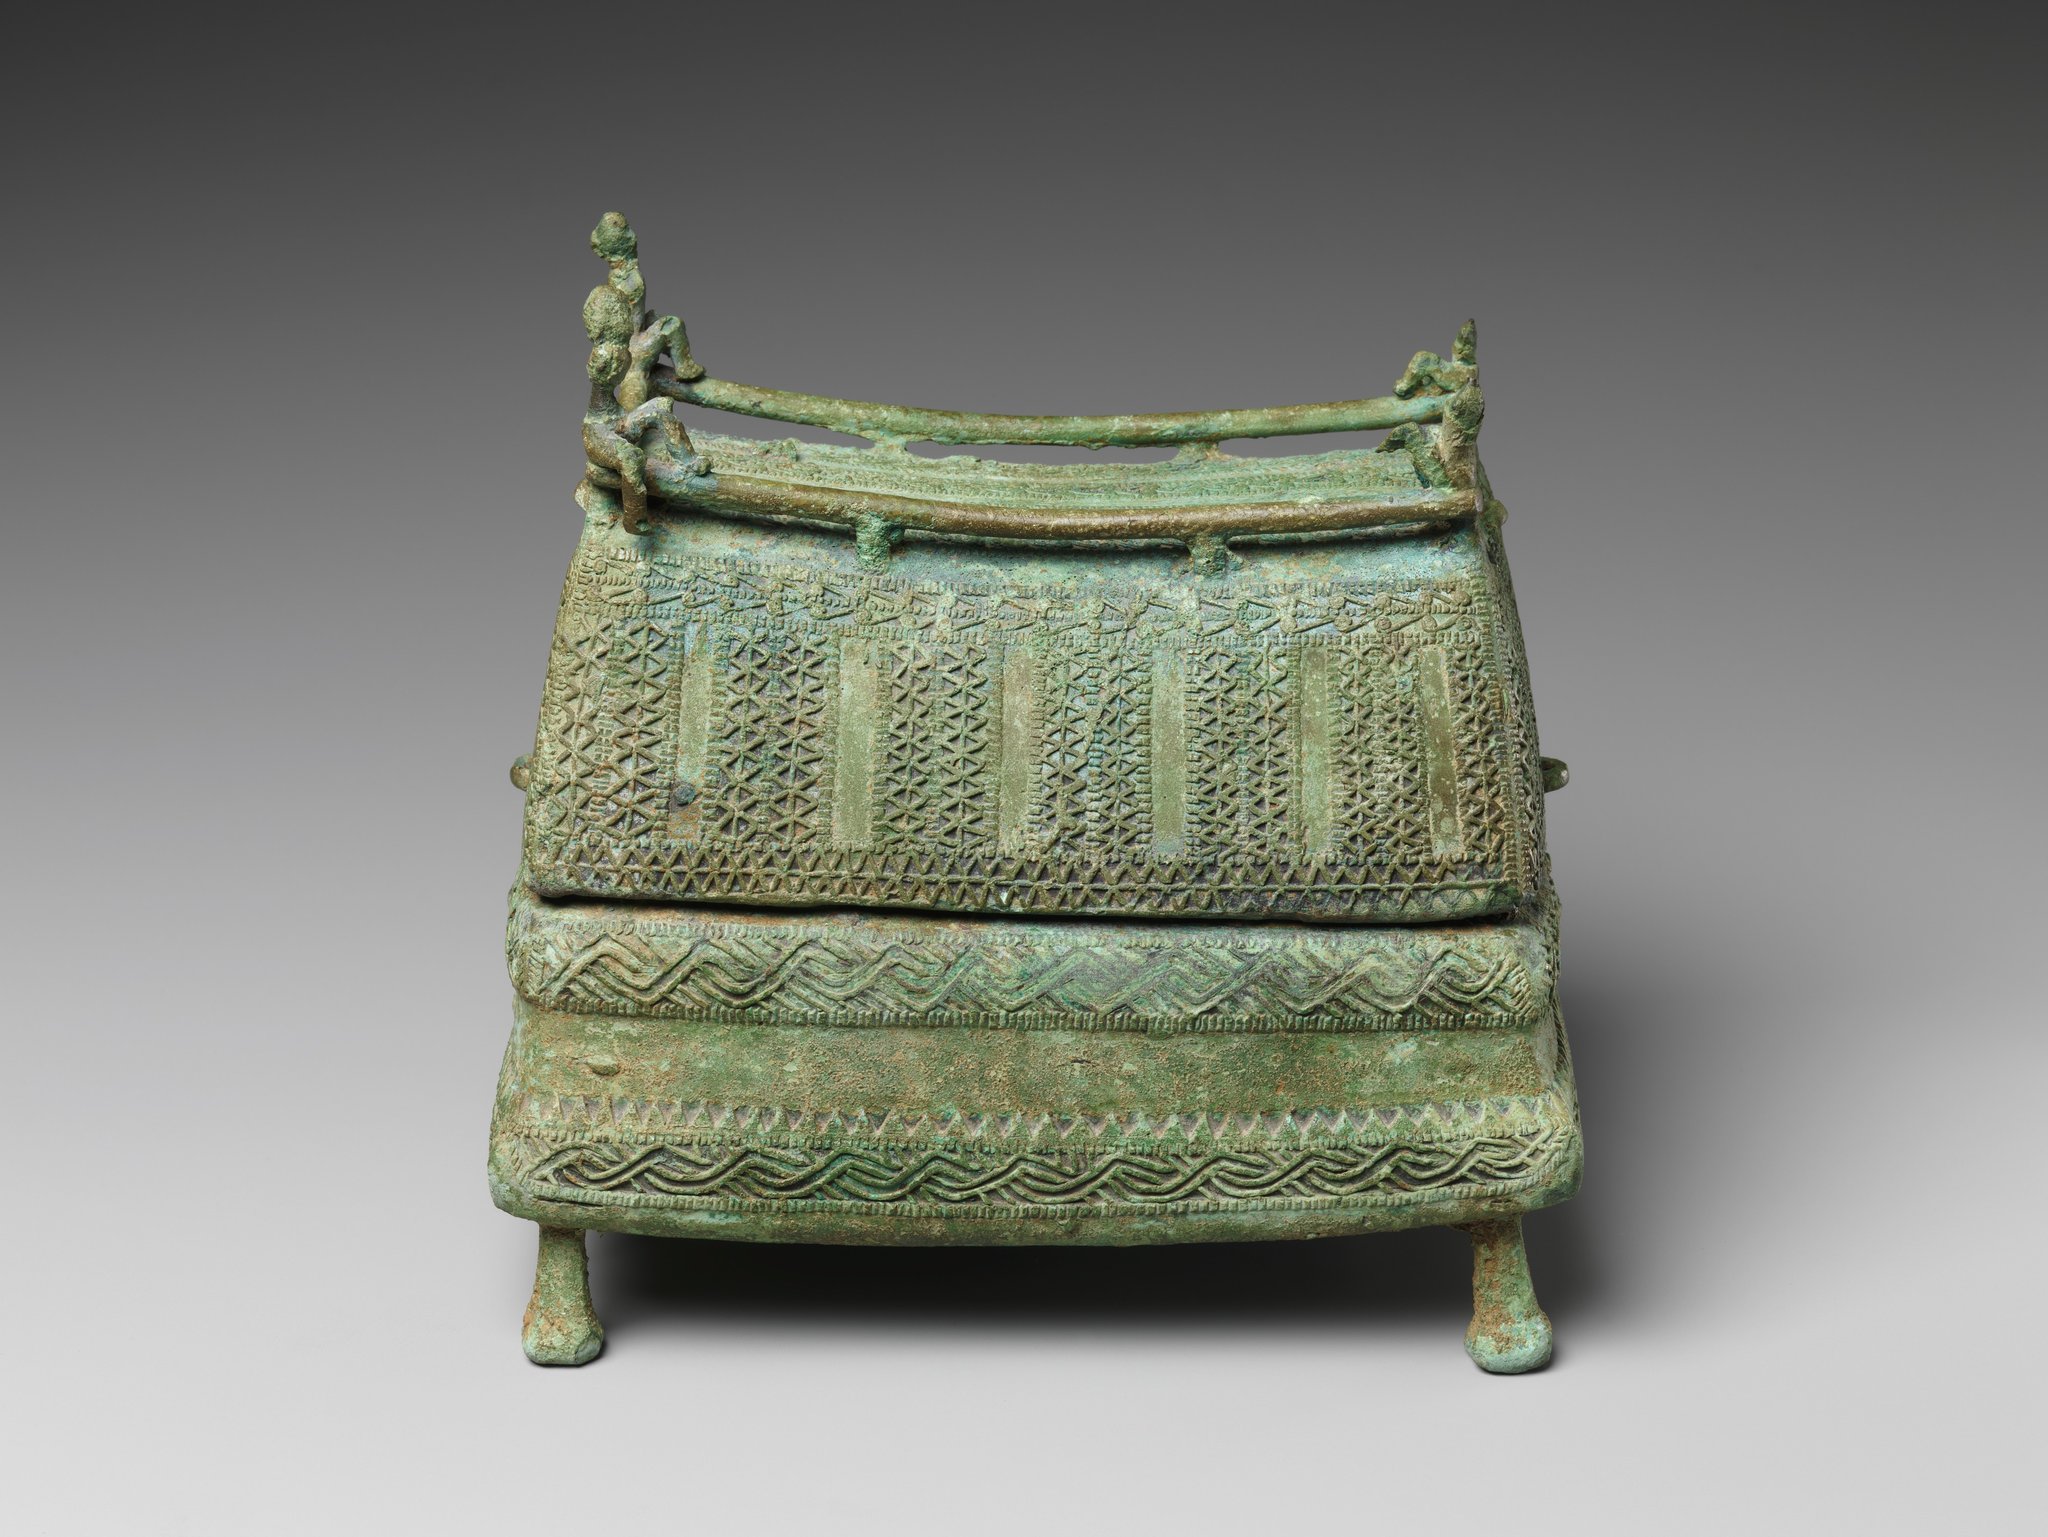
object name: box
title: Box for Betel Leaves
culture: indonesian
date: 500 BCE-300 CE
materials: bronze